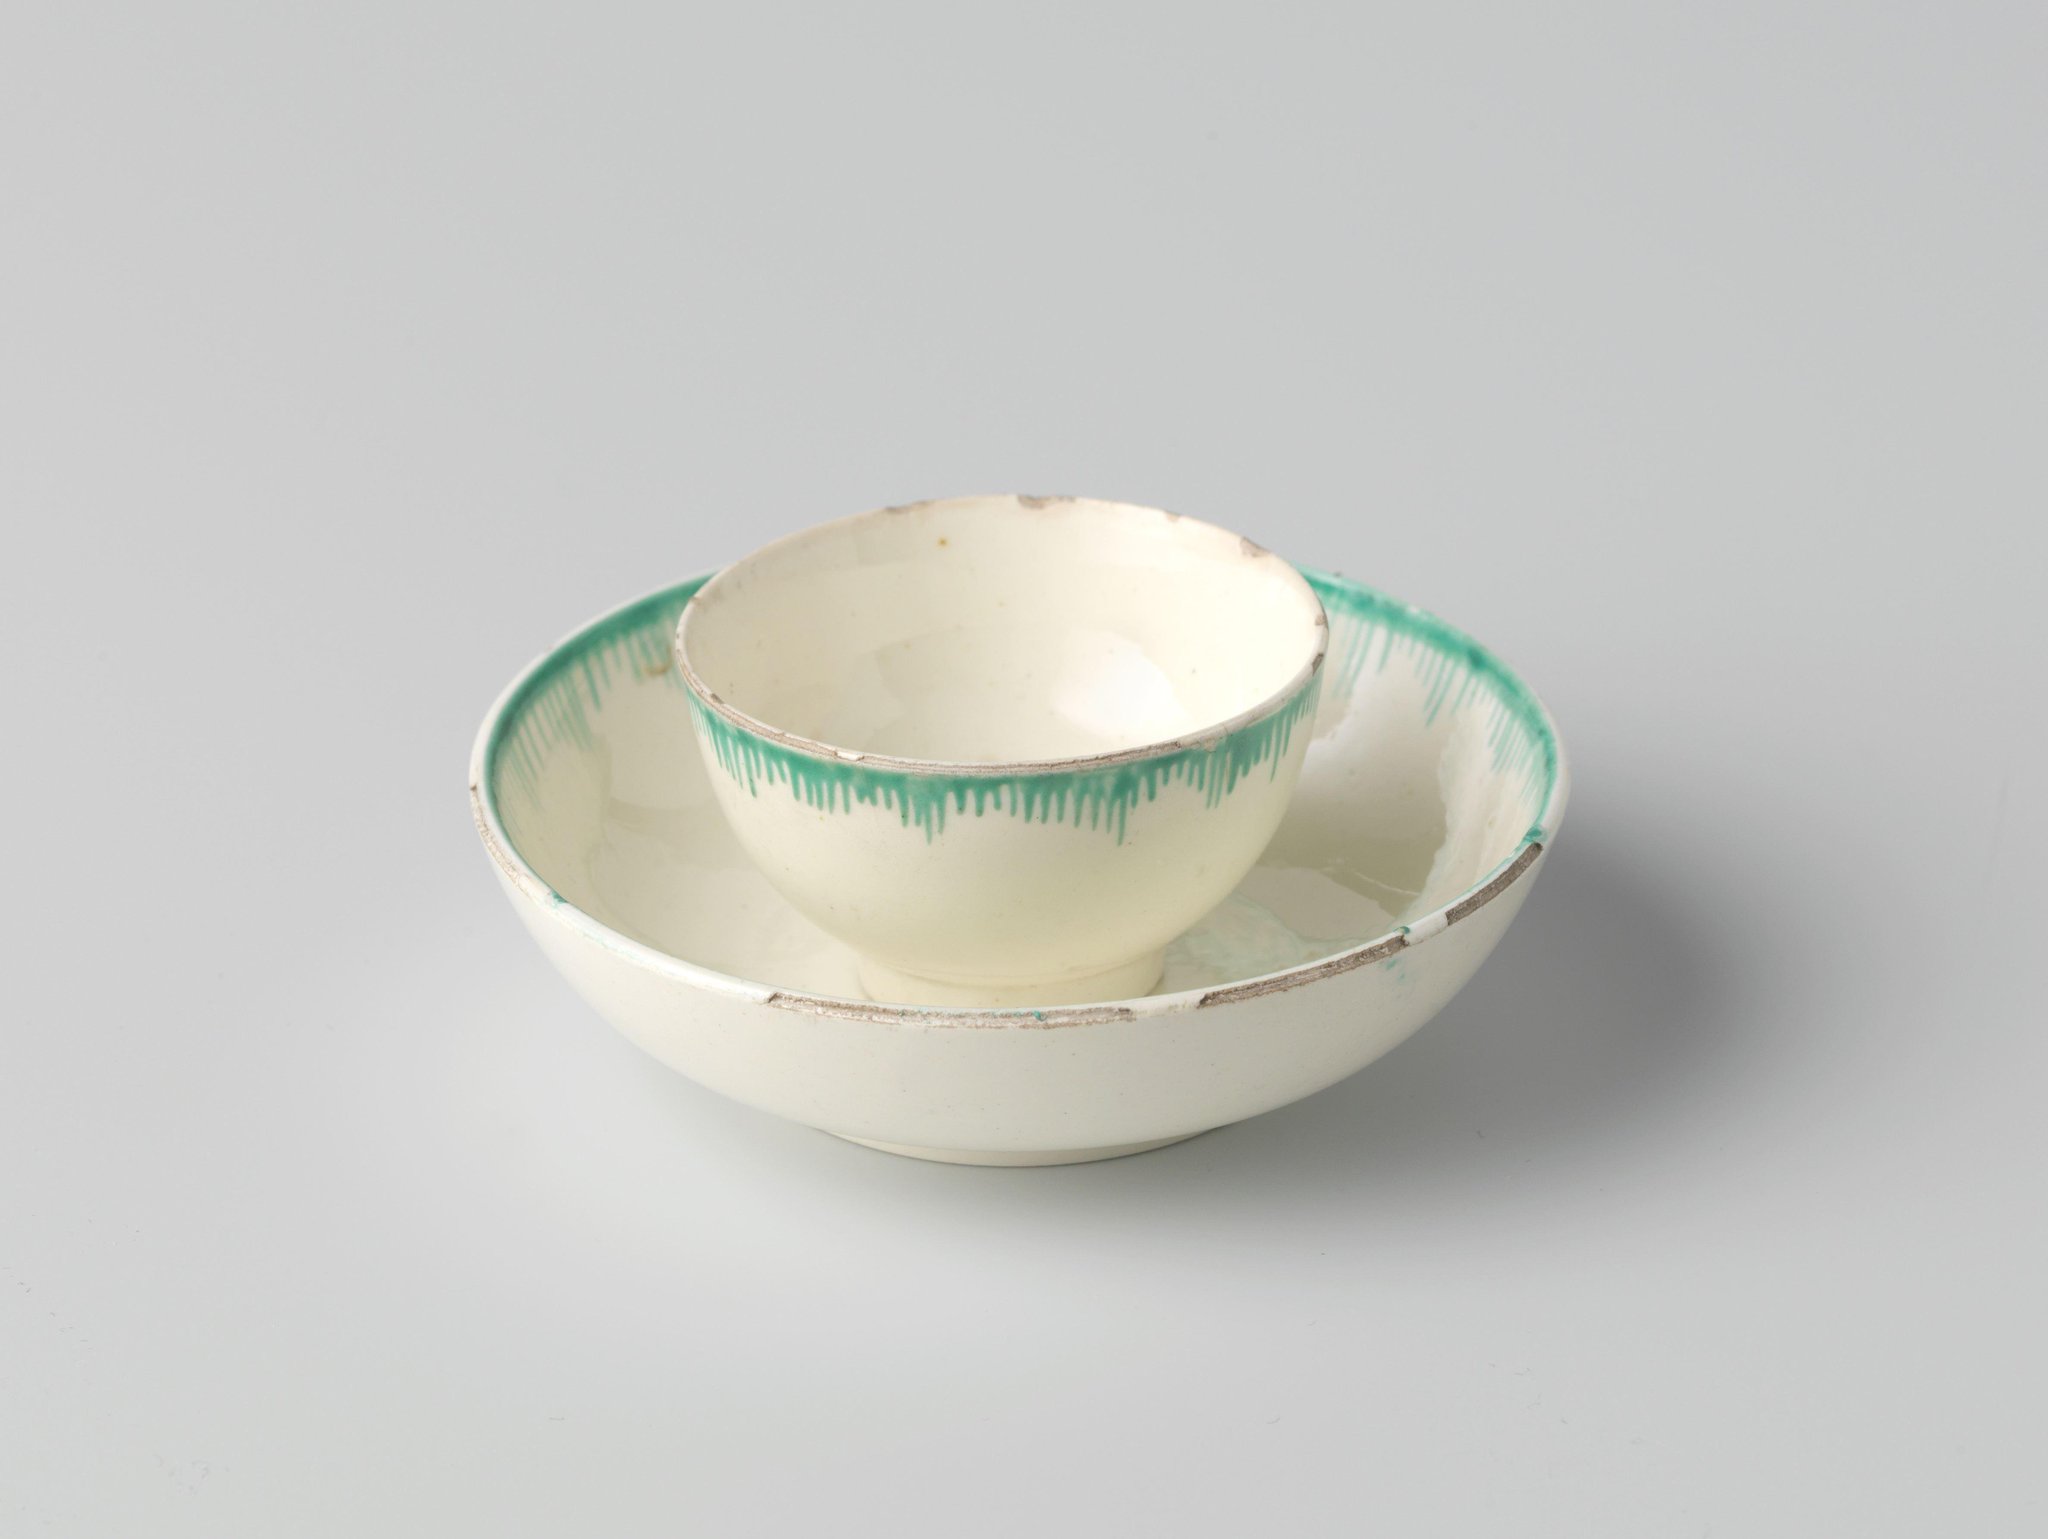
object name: kop en schotel, kop en schotel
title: Schotel van hardgebakken aardewerk, creamware.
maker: Anonymous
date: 1790-1810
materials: earthenware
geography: england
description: Schotel van hardgebakken aardewerk, van een kinderservies. Schotel heeft een groene uitstralende rand.